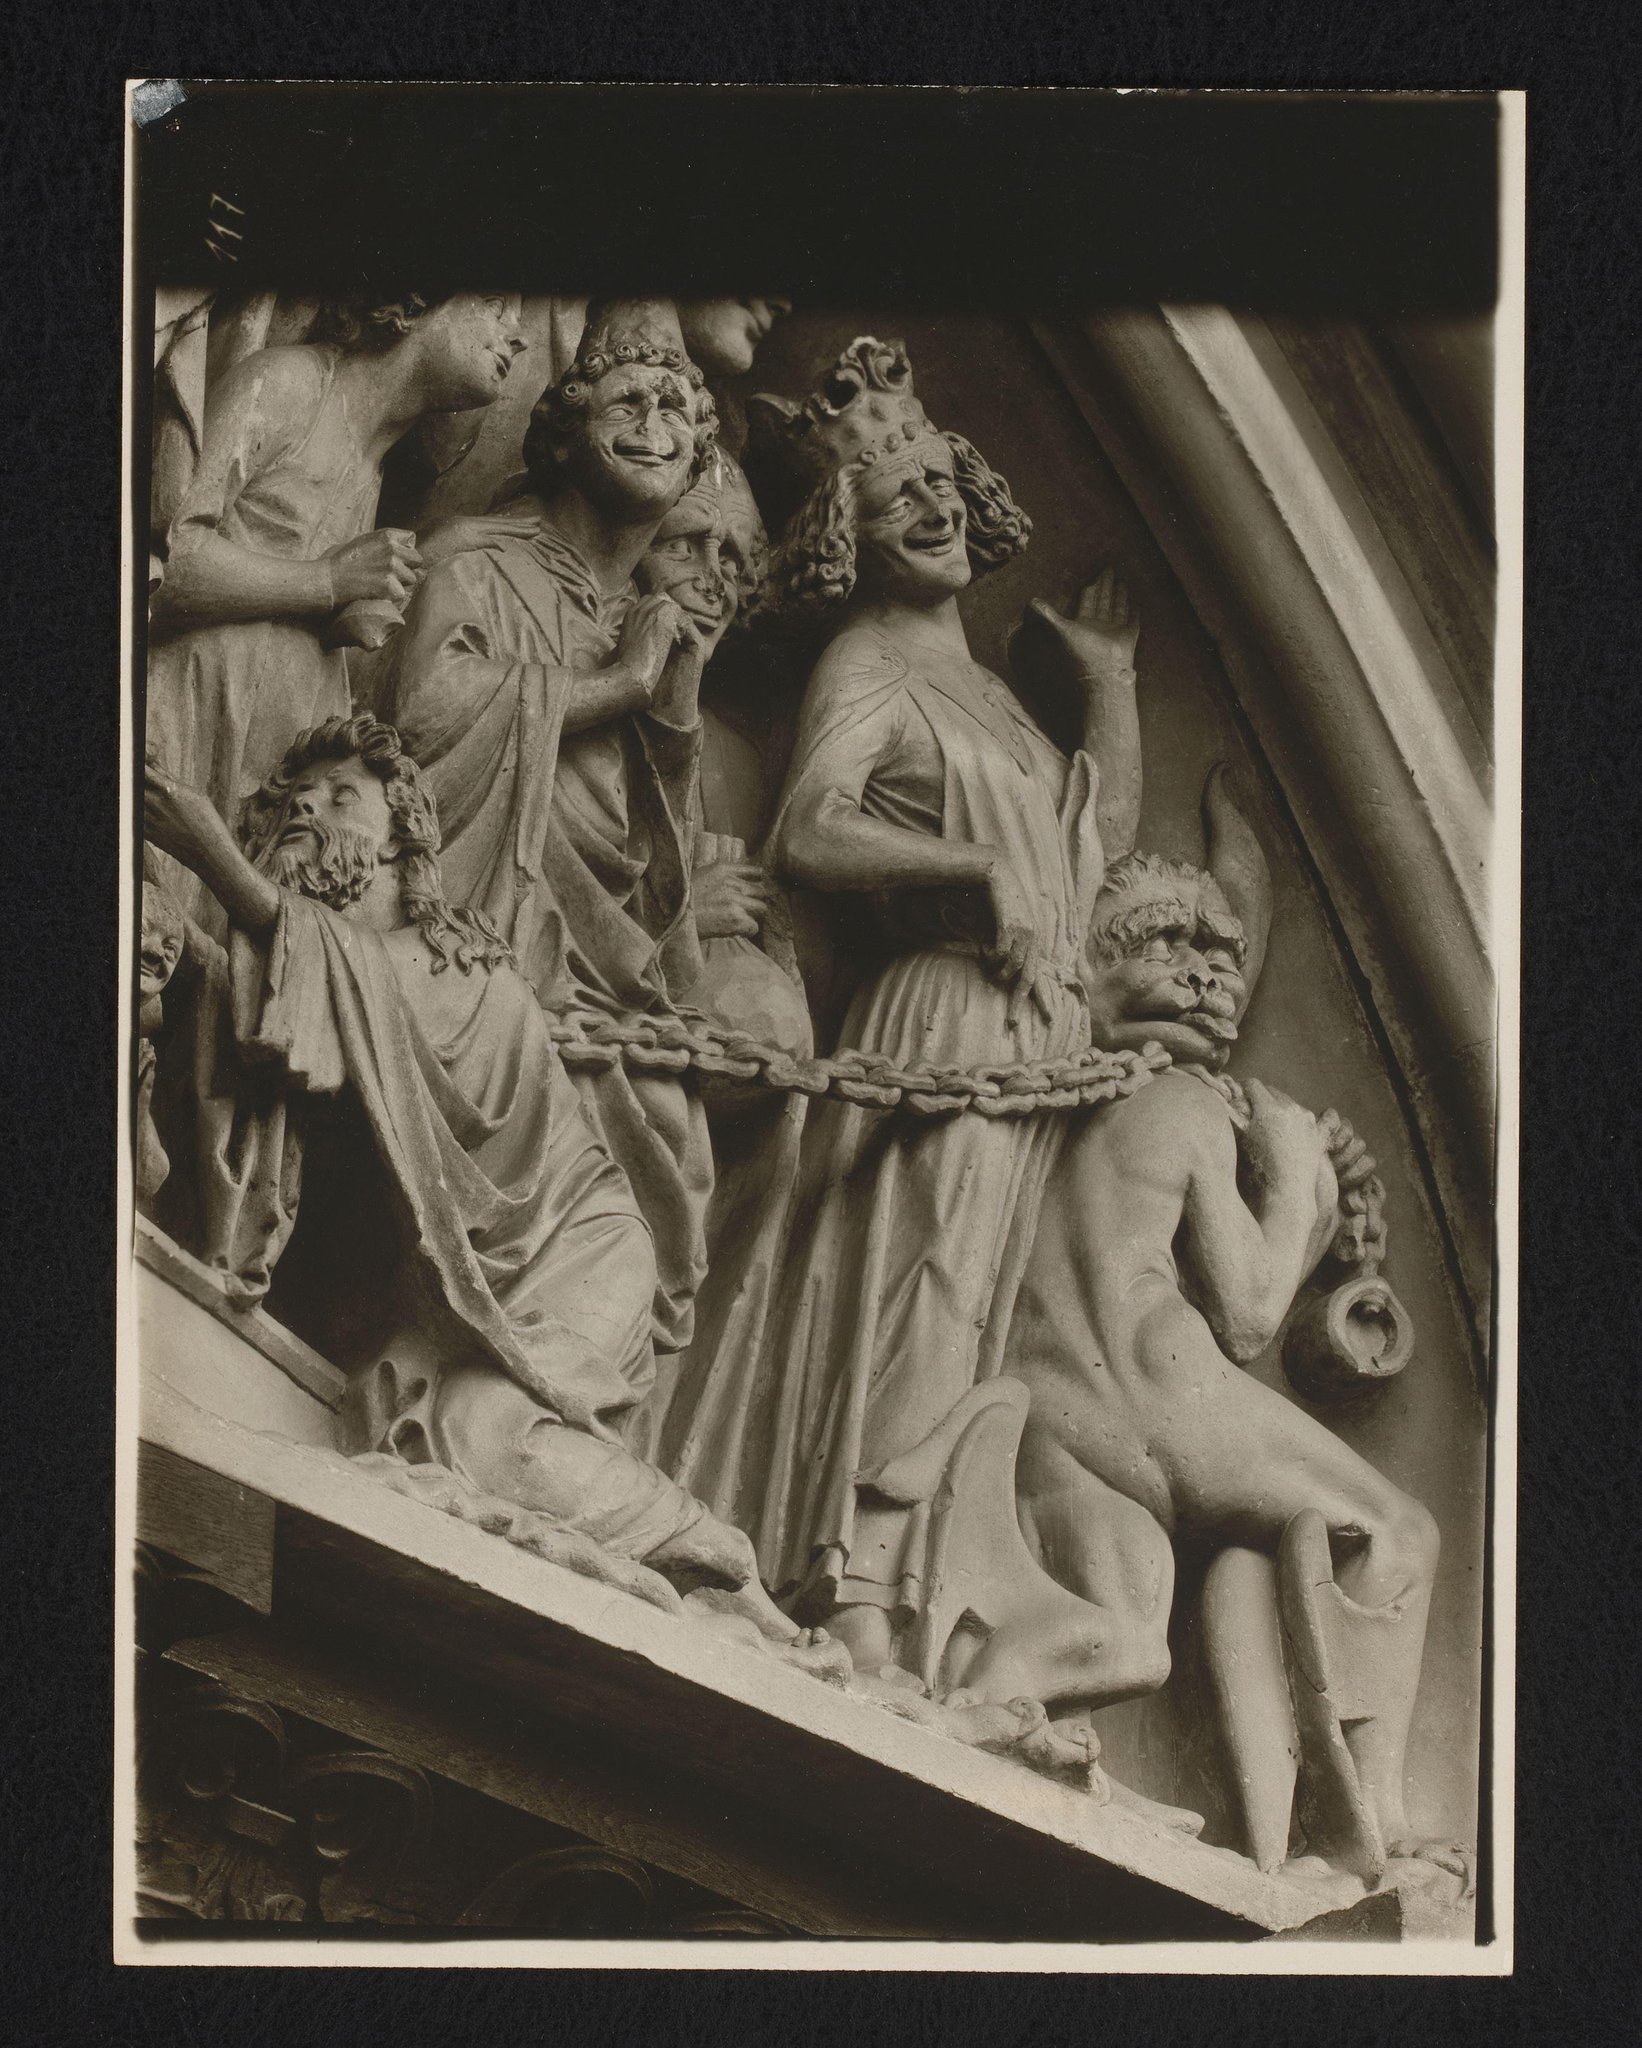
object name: photograph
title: Detail van het timpaan van het Fürstenportal in de dom van Bamberg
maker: Anonymous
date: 1900-1920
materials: paper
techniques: gelatin silver print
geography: bamberg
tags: church (exterior)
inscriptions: inscription: ‘Kunsthist. Seminar/ Marburg (Lahn)/ Photogr. Abteilung/ Vervielfältigung/ untersagt.’, number: ‘Bamberg/ 117’